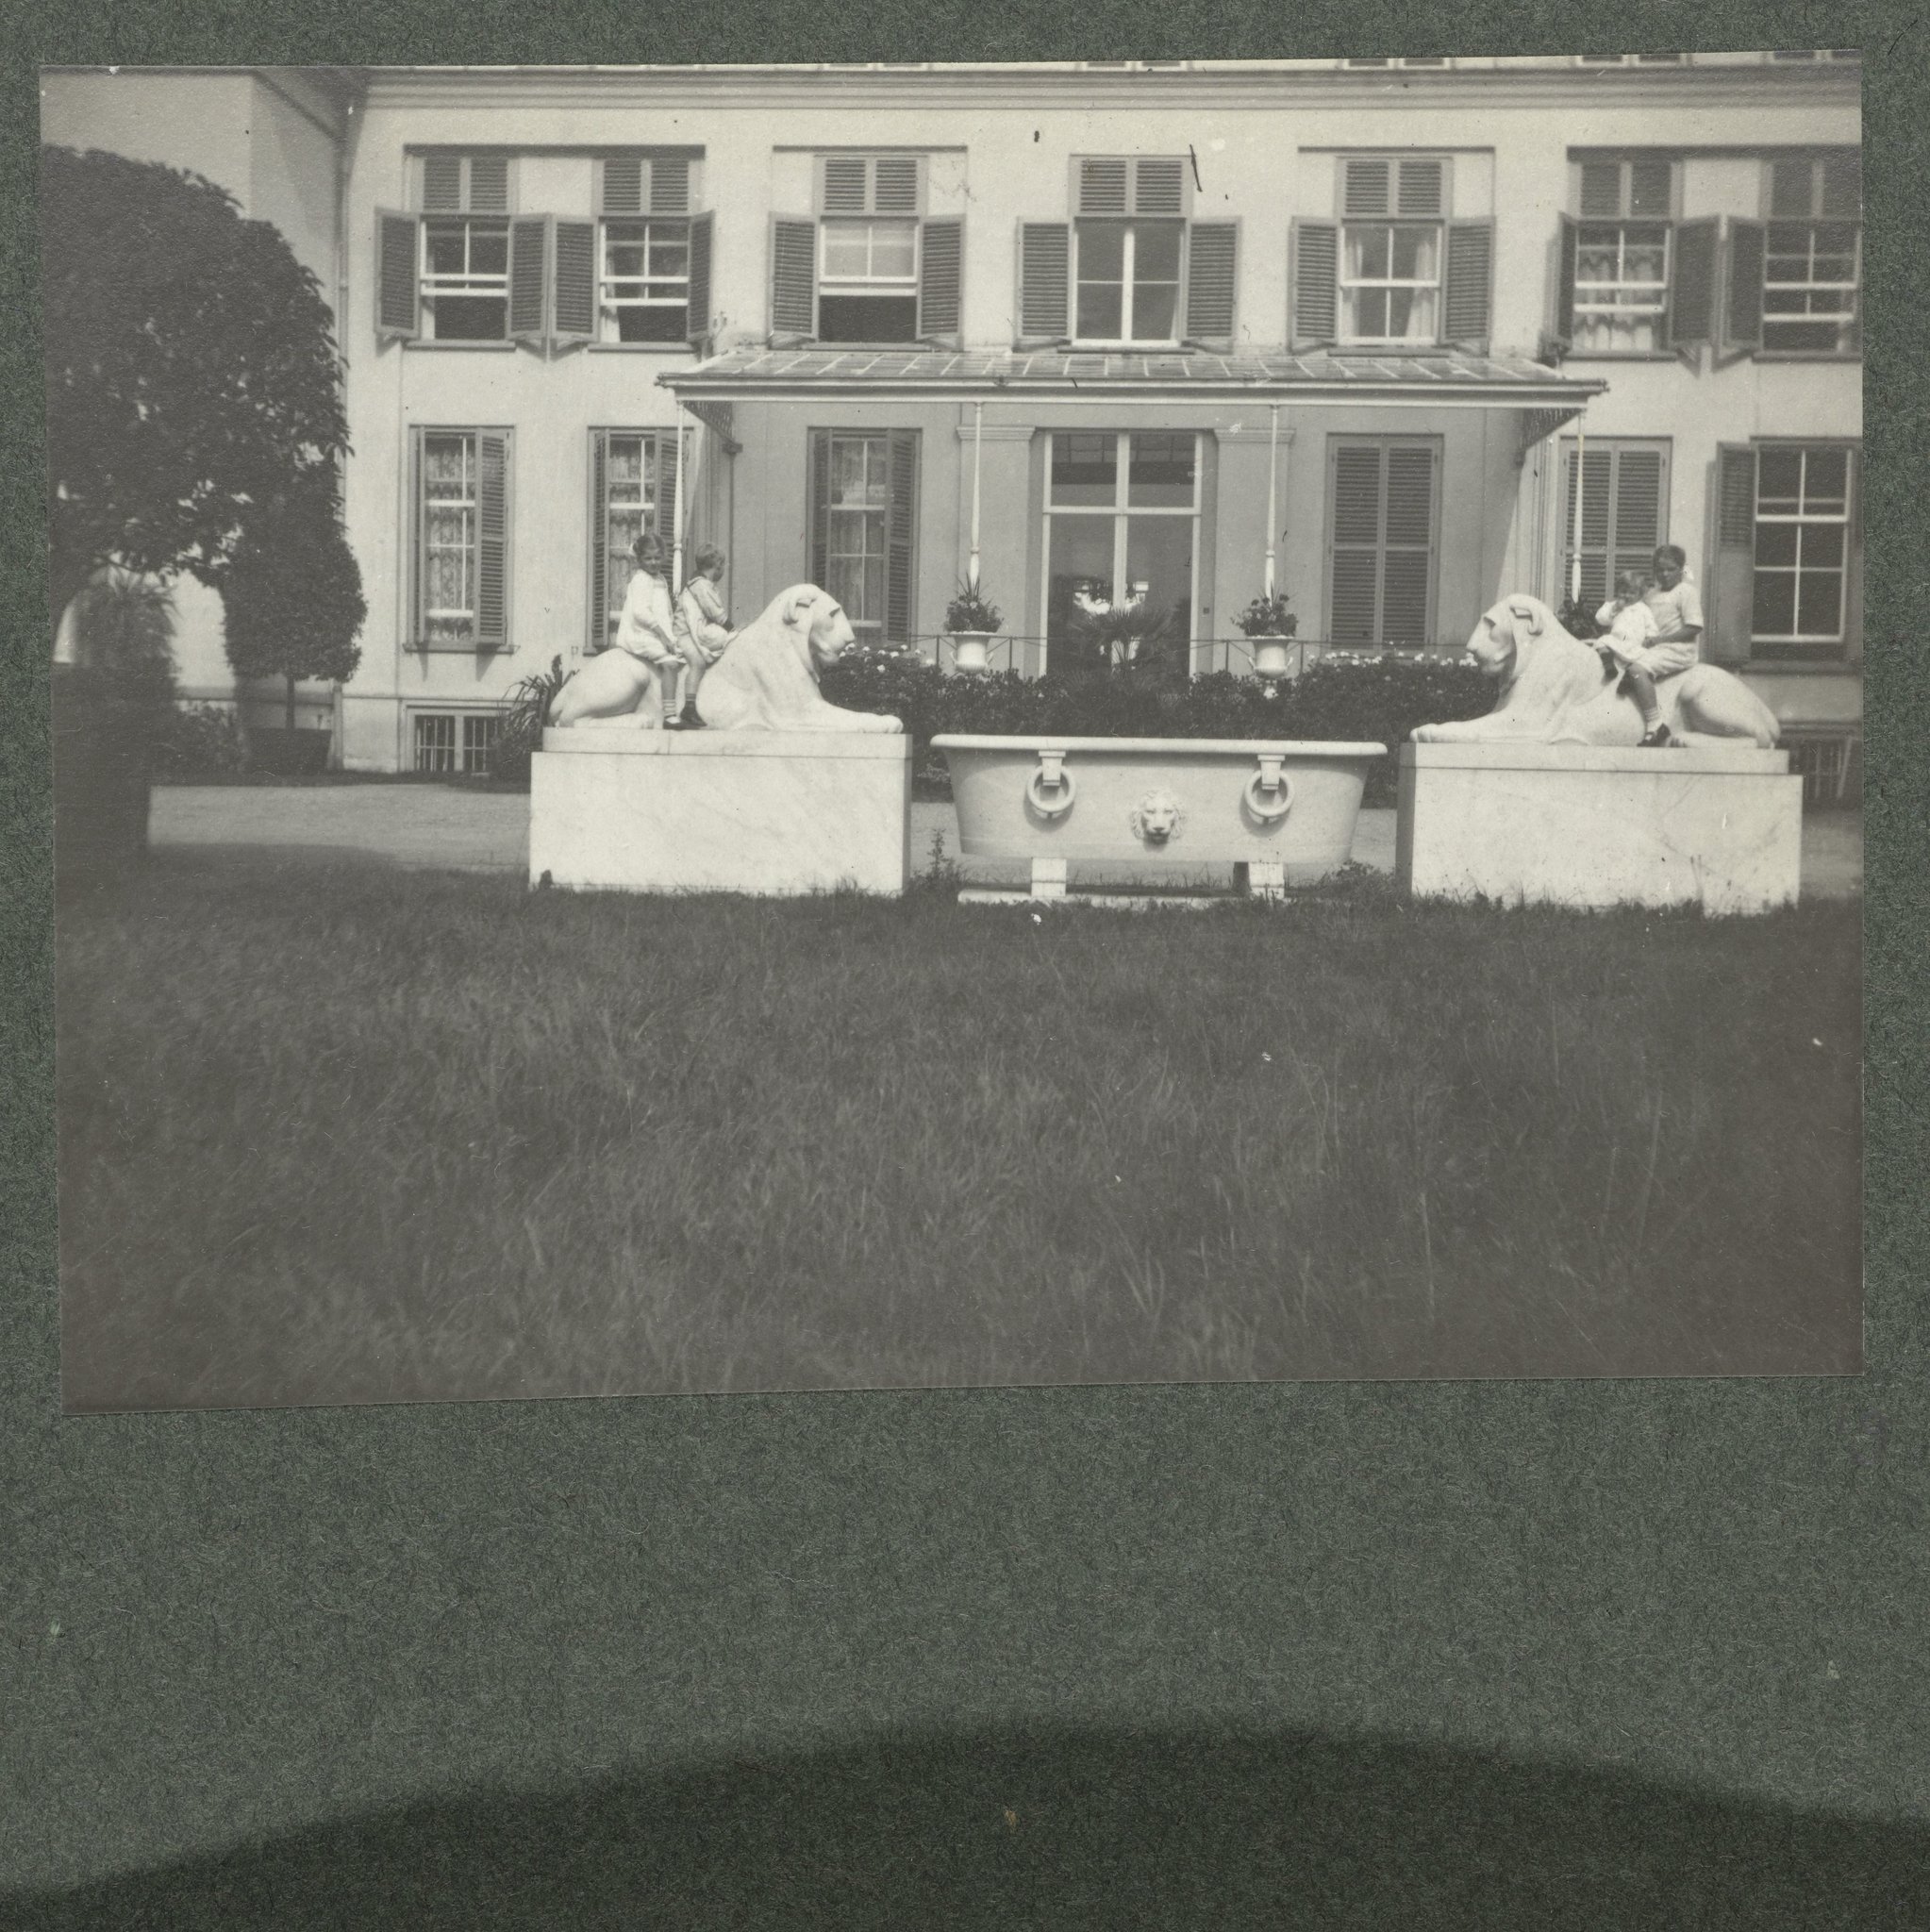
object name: photograph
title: Kinderen op leeuwenbeelden voor Landgoed De Paauw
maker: geldolph adriaan kessler (dolph)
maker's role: fotograaf, industrieel, voetballer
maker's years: 1884-1945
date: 1913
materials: paper, photographic support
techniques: gelatin silver print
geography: netherlands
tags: huize de paauw